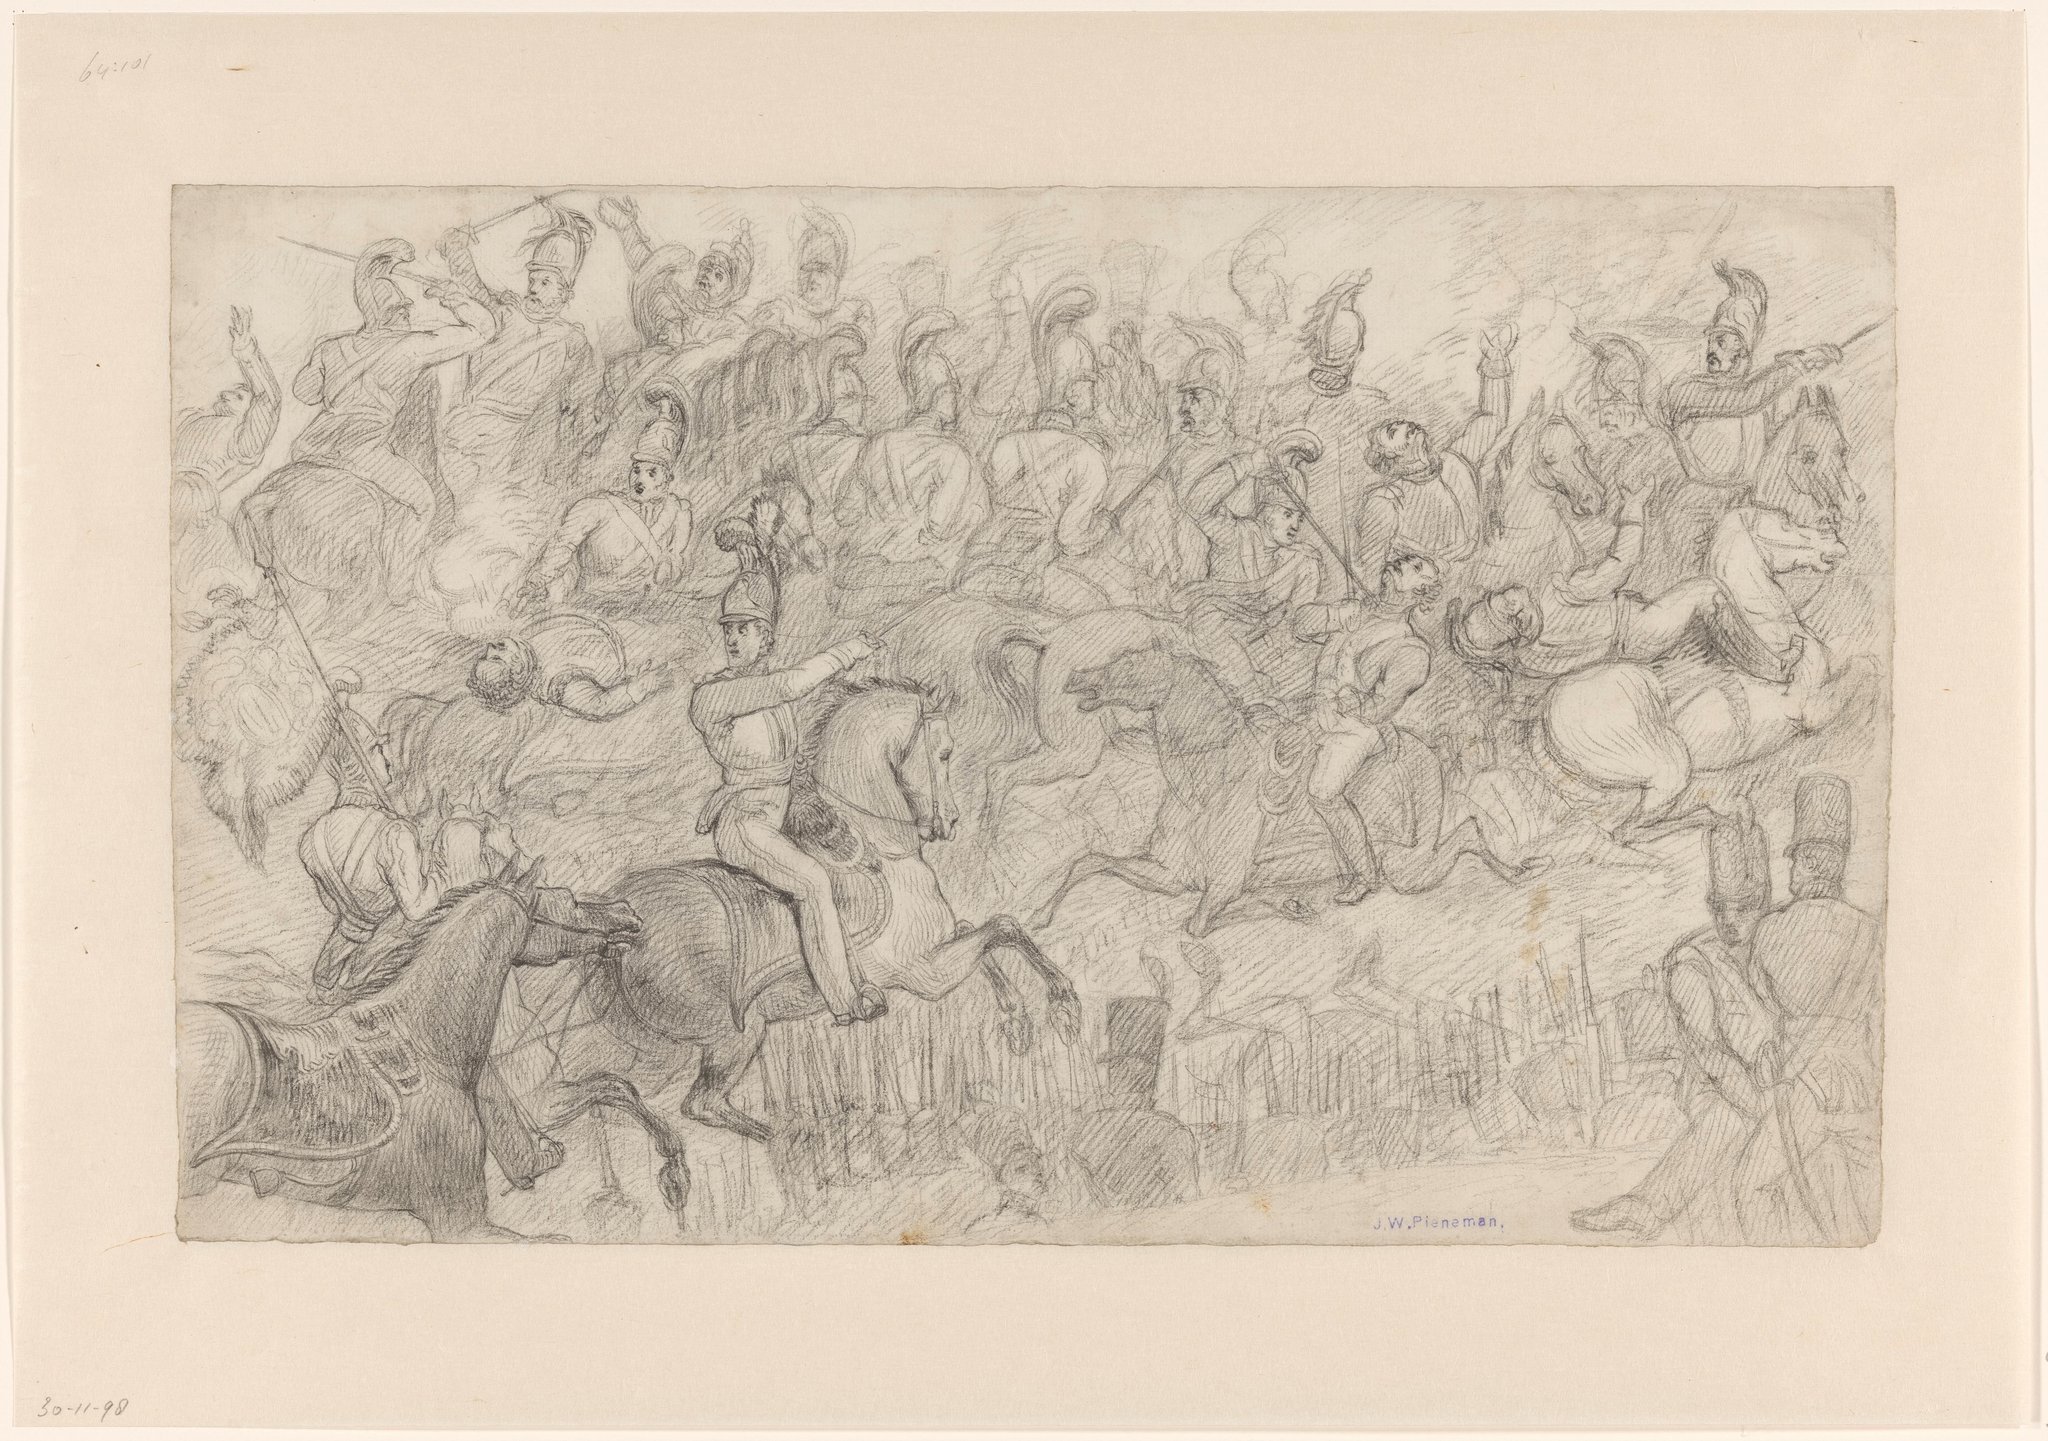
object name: drawing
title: Study for The Battle of Waterloo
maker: jan willem pieneman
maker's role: draughtsman, painter, print maker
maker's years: 1779-1853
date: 1824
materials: chalk, paper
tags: battle (+ land forces), historical events and situations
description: Pieneman’s studies depict individual combats more clearly than his large painting. Amid the chaos in the centre of this drawing one man is being despatched by a pistol shot, while another succumbs to a deadly sabre thrust. At the lower left a horse without a rider gallops into the scene, which represents an attack by German mercenaries in Wellington’s army.